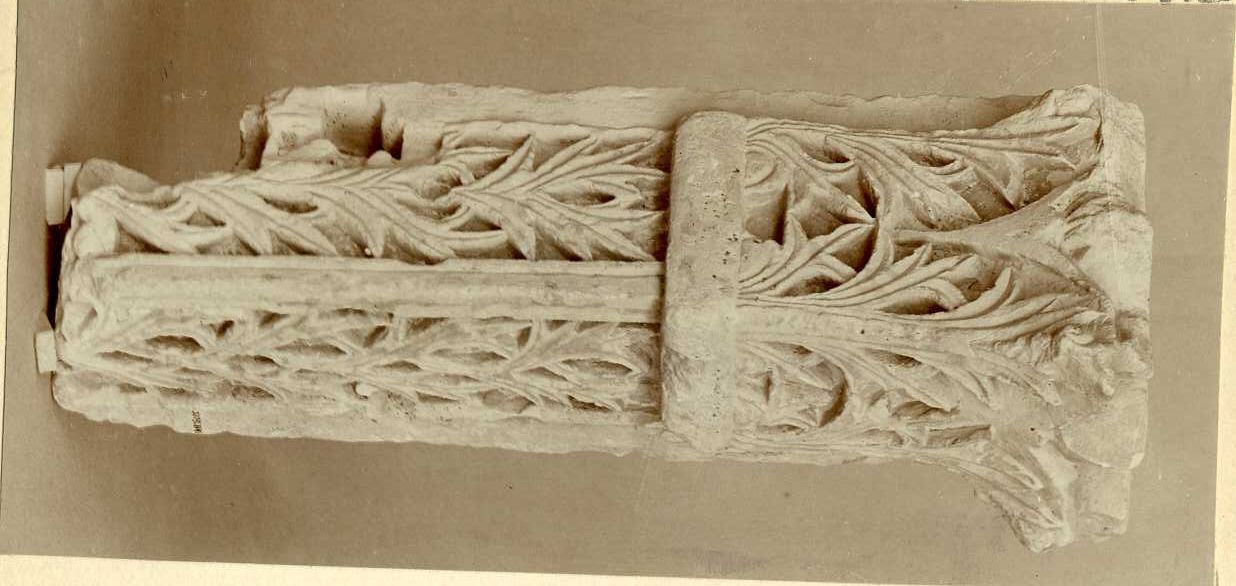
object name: fragment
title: Fragment of a Door Post with Acanthus Leaves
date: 501-700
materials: limestone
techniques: carving, relief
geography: egypt